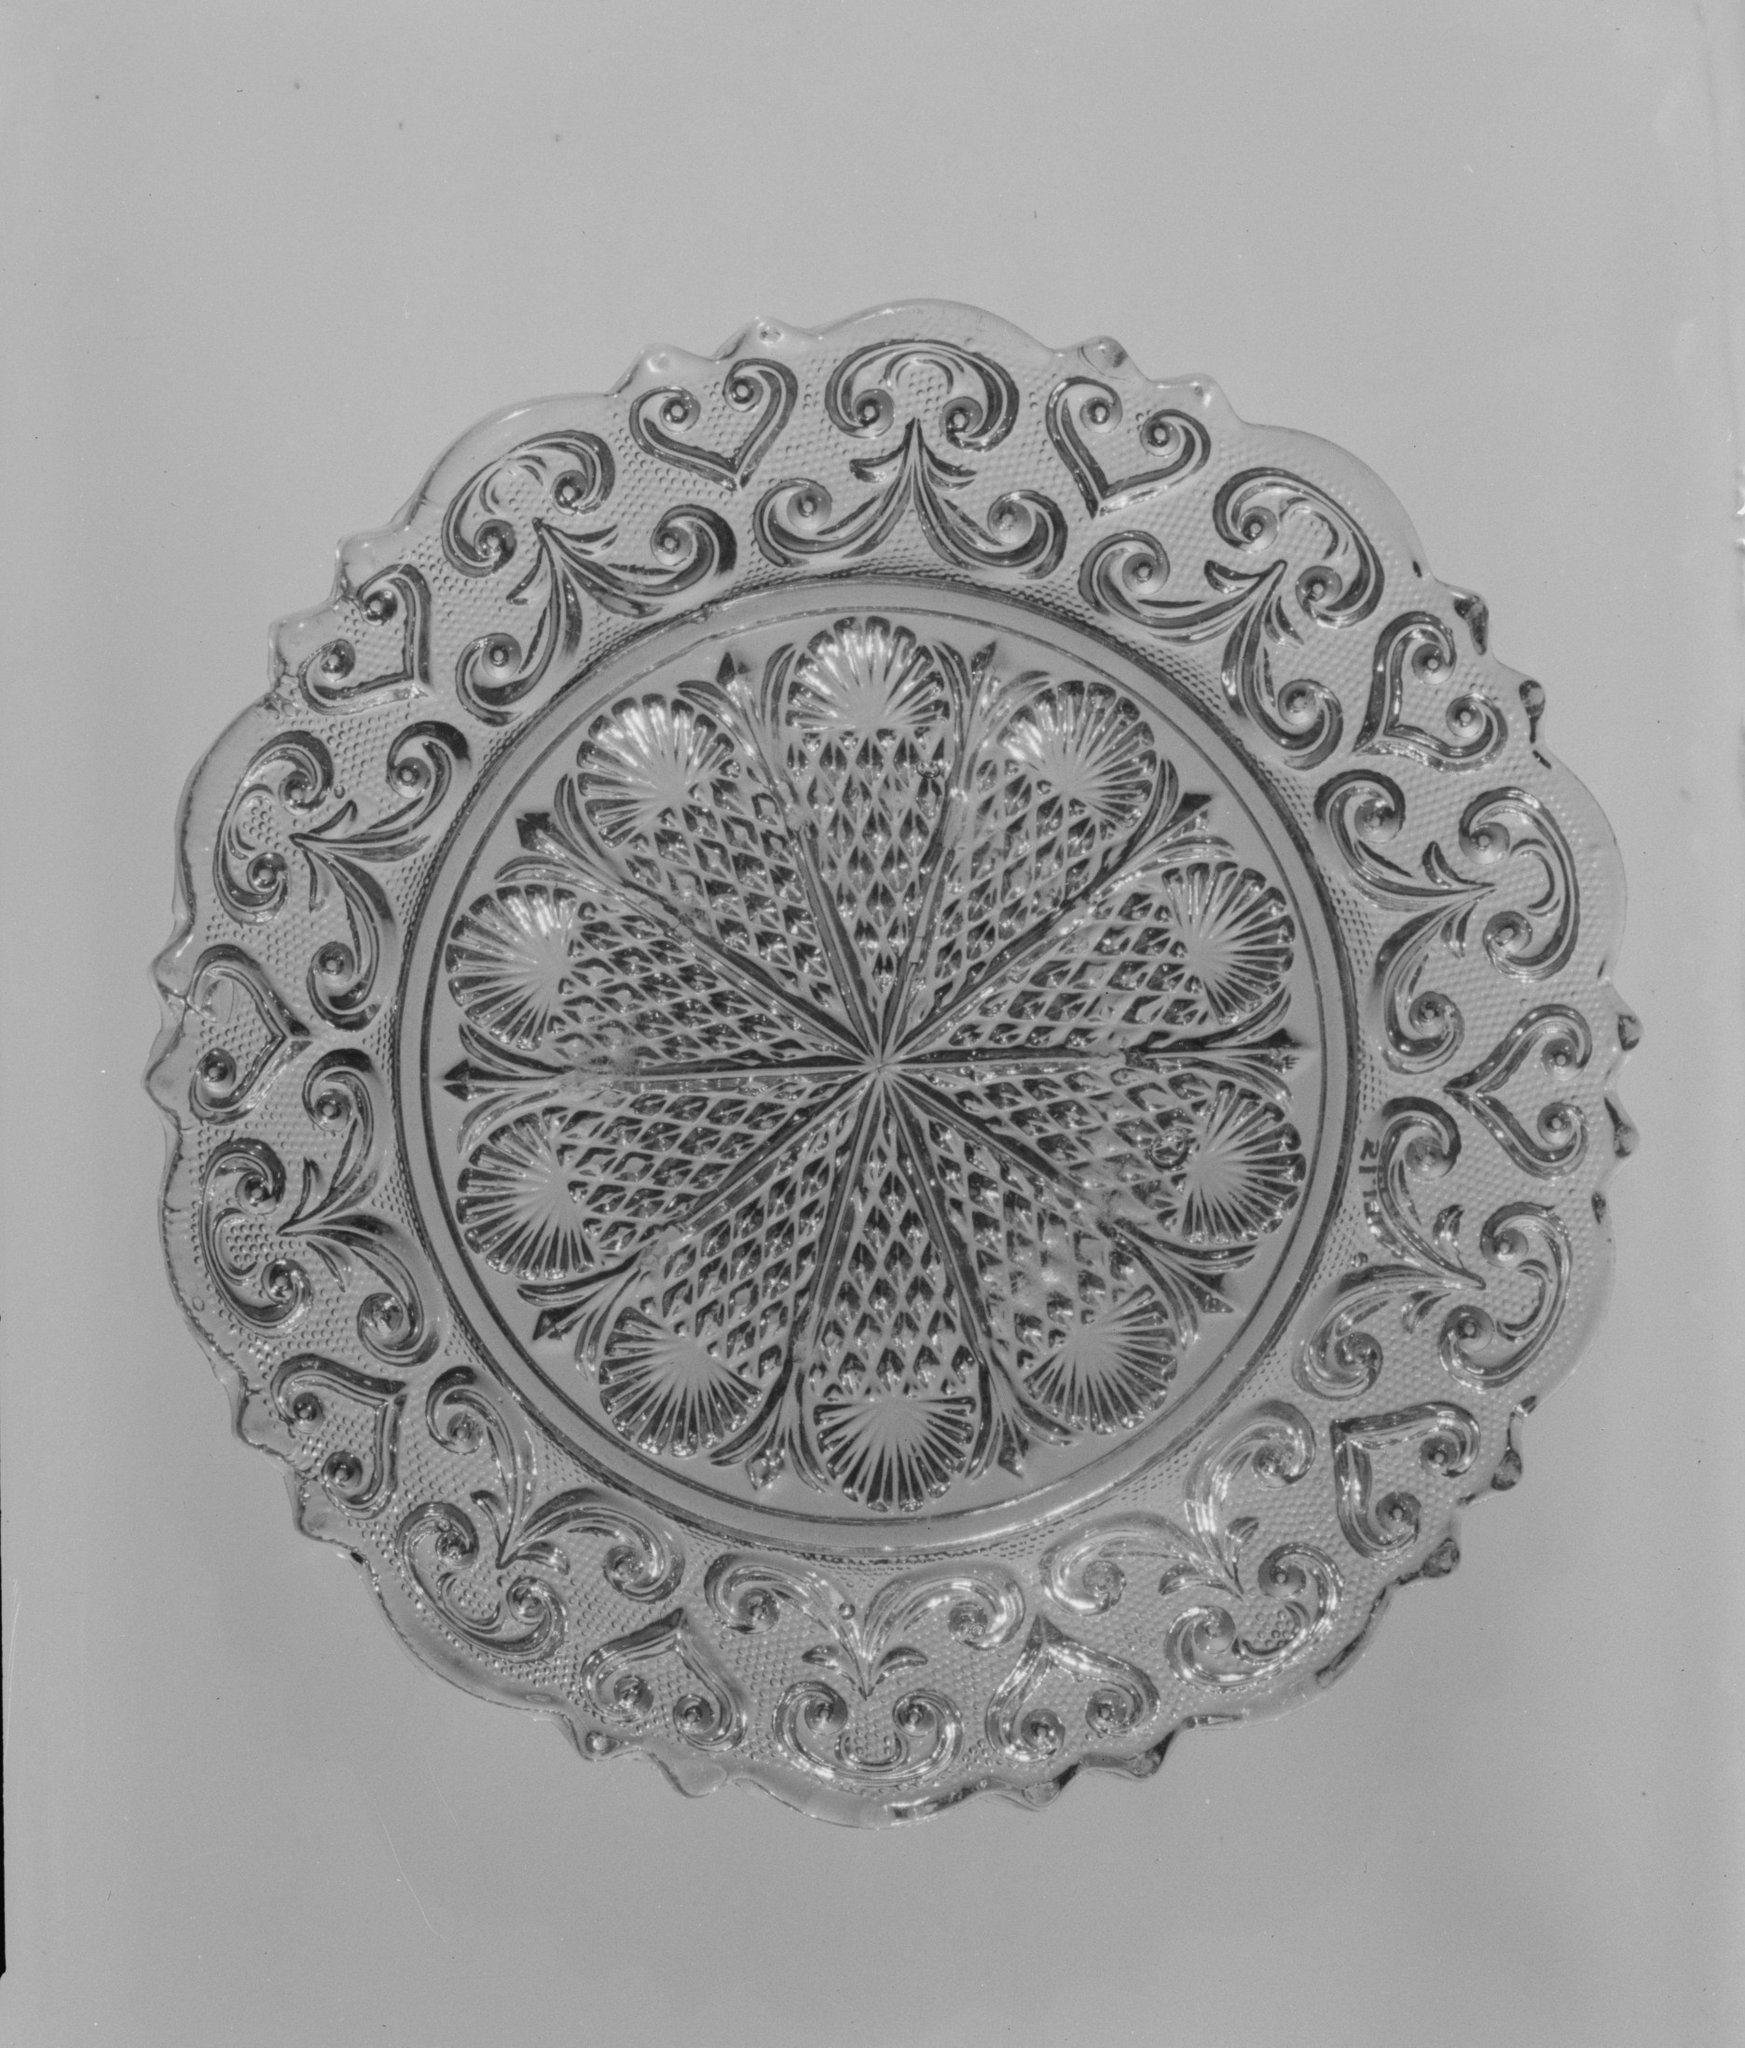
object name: dish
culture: american or french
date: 1835-1850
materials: glass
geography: france